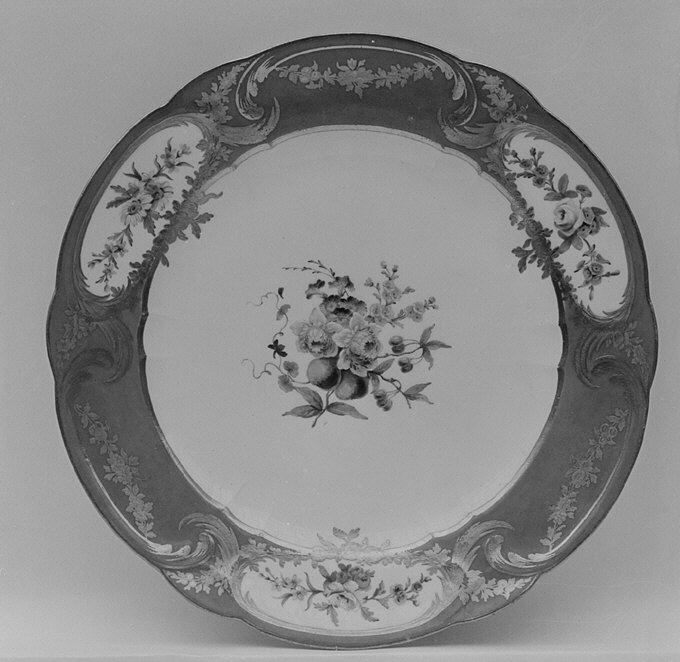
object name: plate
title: Plate (assiette à palmes) (1 of 102) (part of a service)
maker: sèvres manufactory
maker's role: manufactory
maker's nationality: french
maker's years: 1740-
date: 1786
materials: soft paste porcelain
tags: flowers